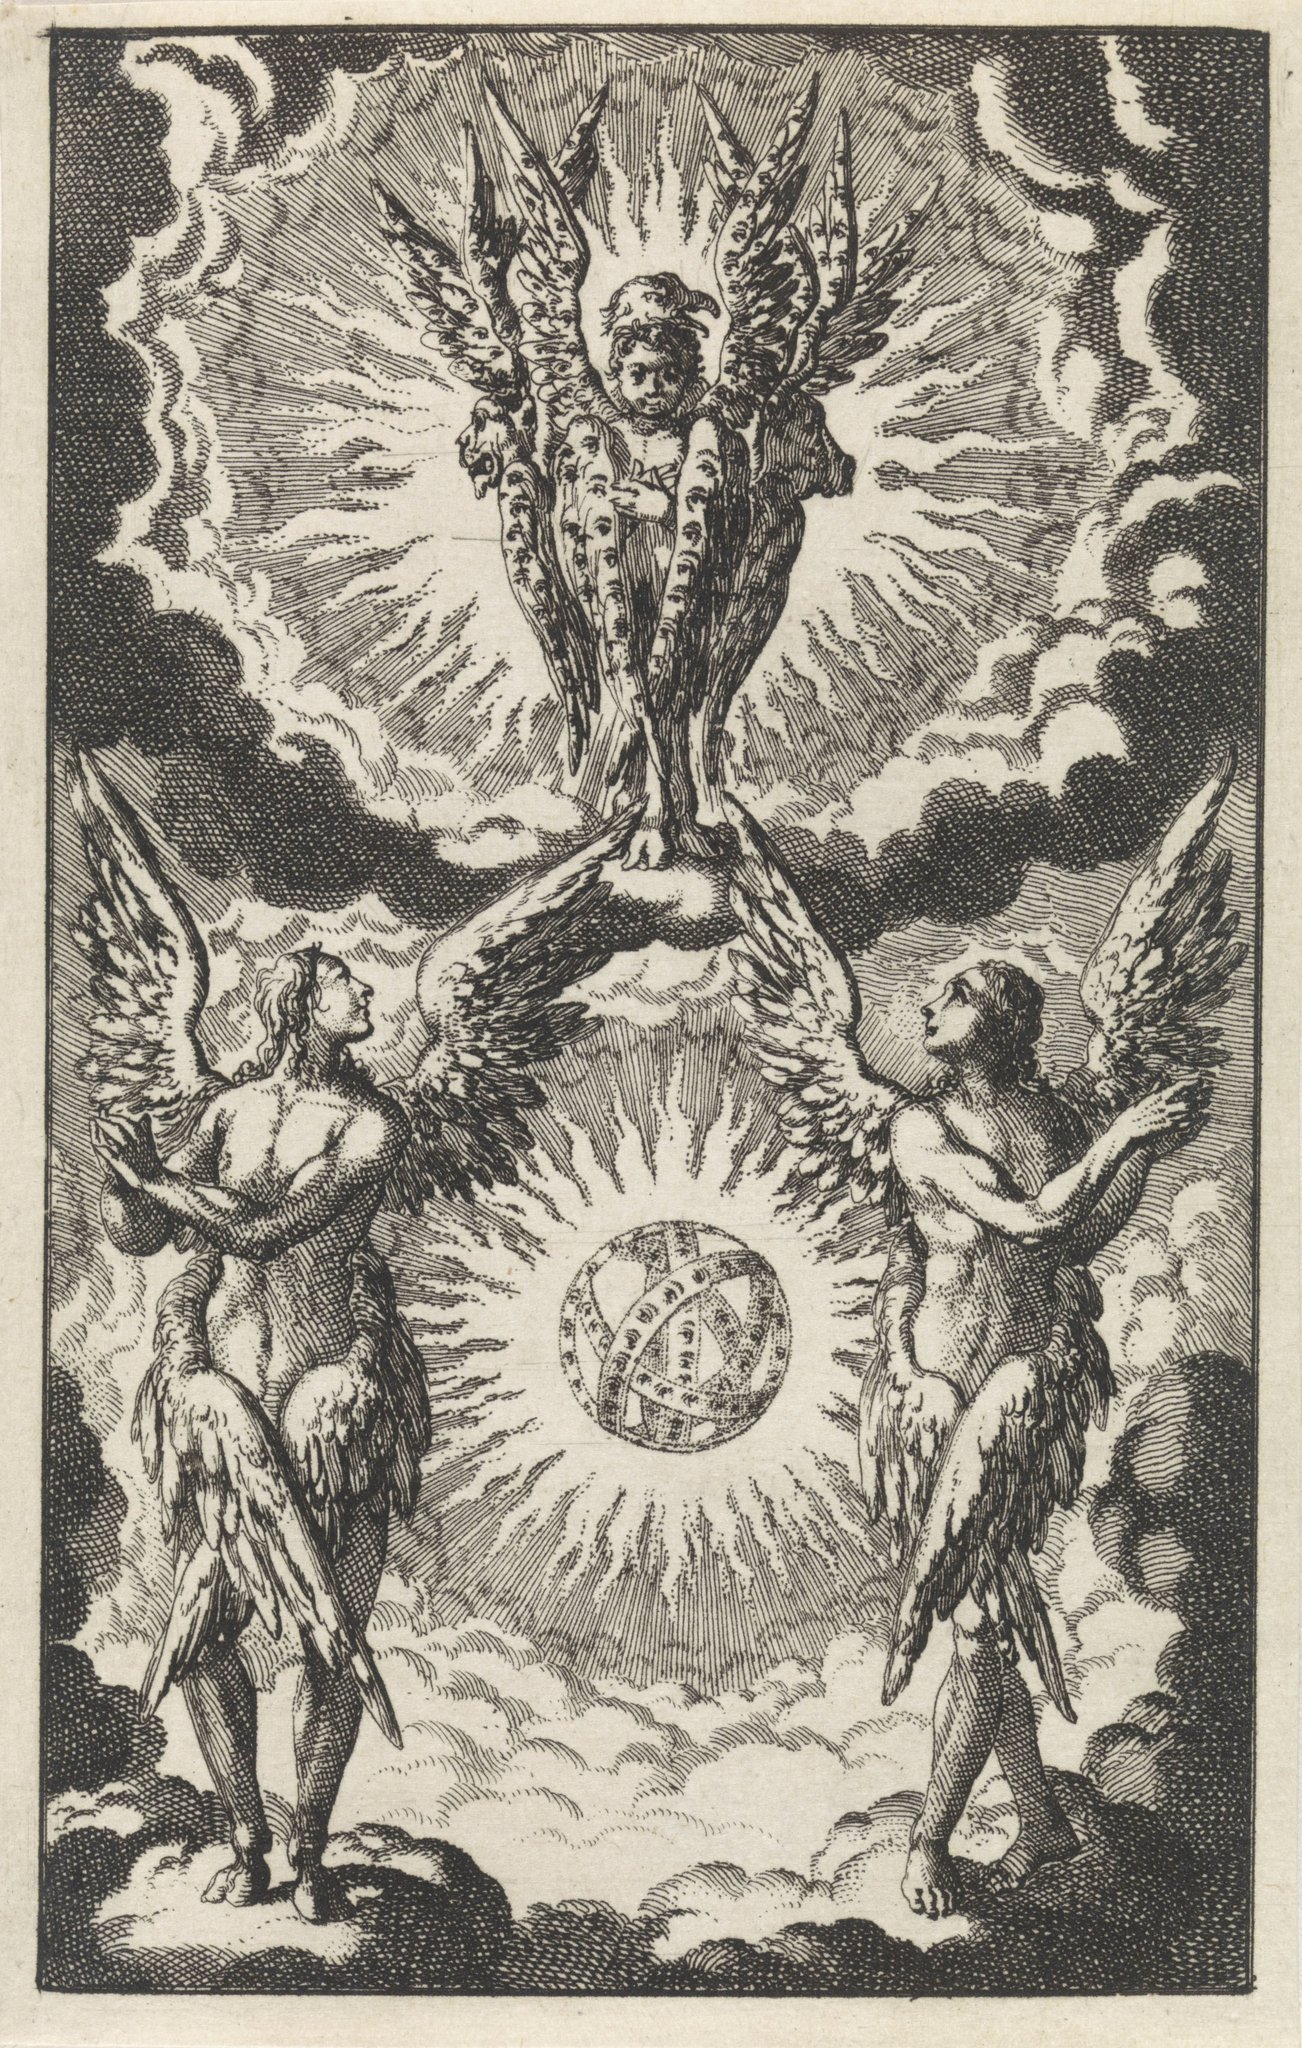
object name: print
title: Verschillende cherubijnen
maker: jan luyken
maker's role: draughtsman, print maker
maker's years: 1649-1712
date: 1705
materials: paper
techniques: etching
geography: amsterdam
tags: cherubim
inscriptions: collector's mark: Lugt 2228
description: Proefdruk van illustratie uit: Cunaeus, Petrus. La republique des Hebreux, 3 delen. Amsterdam: Pieter Mortier, 1705, dl. II, p. 64.